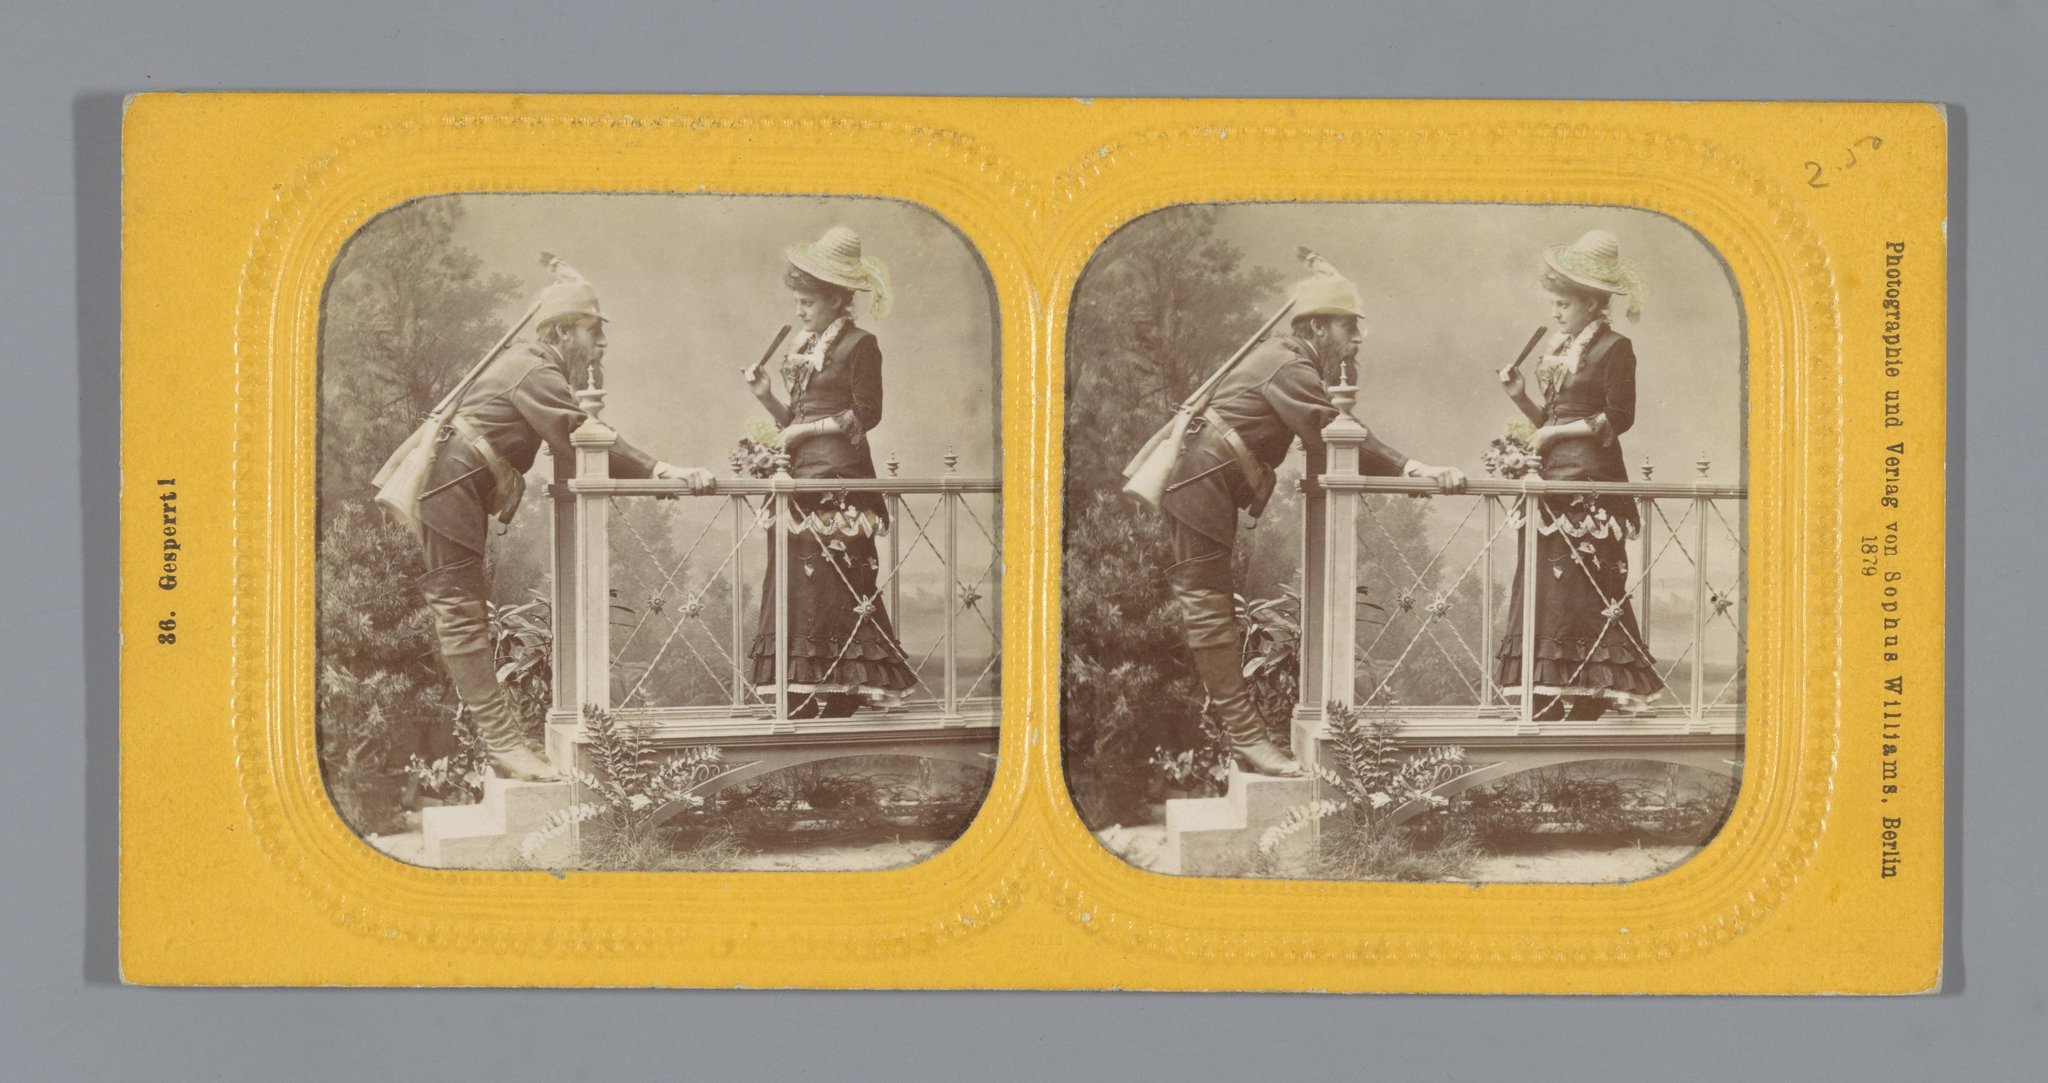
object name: tissue stereograph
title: Gesperrt!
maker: sophus williams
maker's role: publisher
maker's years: 1835-1900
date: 1879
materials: cardboard, paper, photographic support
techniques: albumen print, cutting, hand coloring, perforating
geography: berlin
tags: adult woman, adult man, bridge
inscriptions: number: ‘36.’, inscription: ‘2.50’